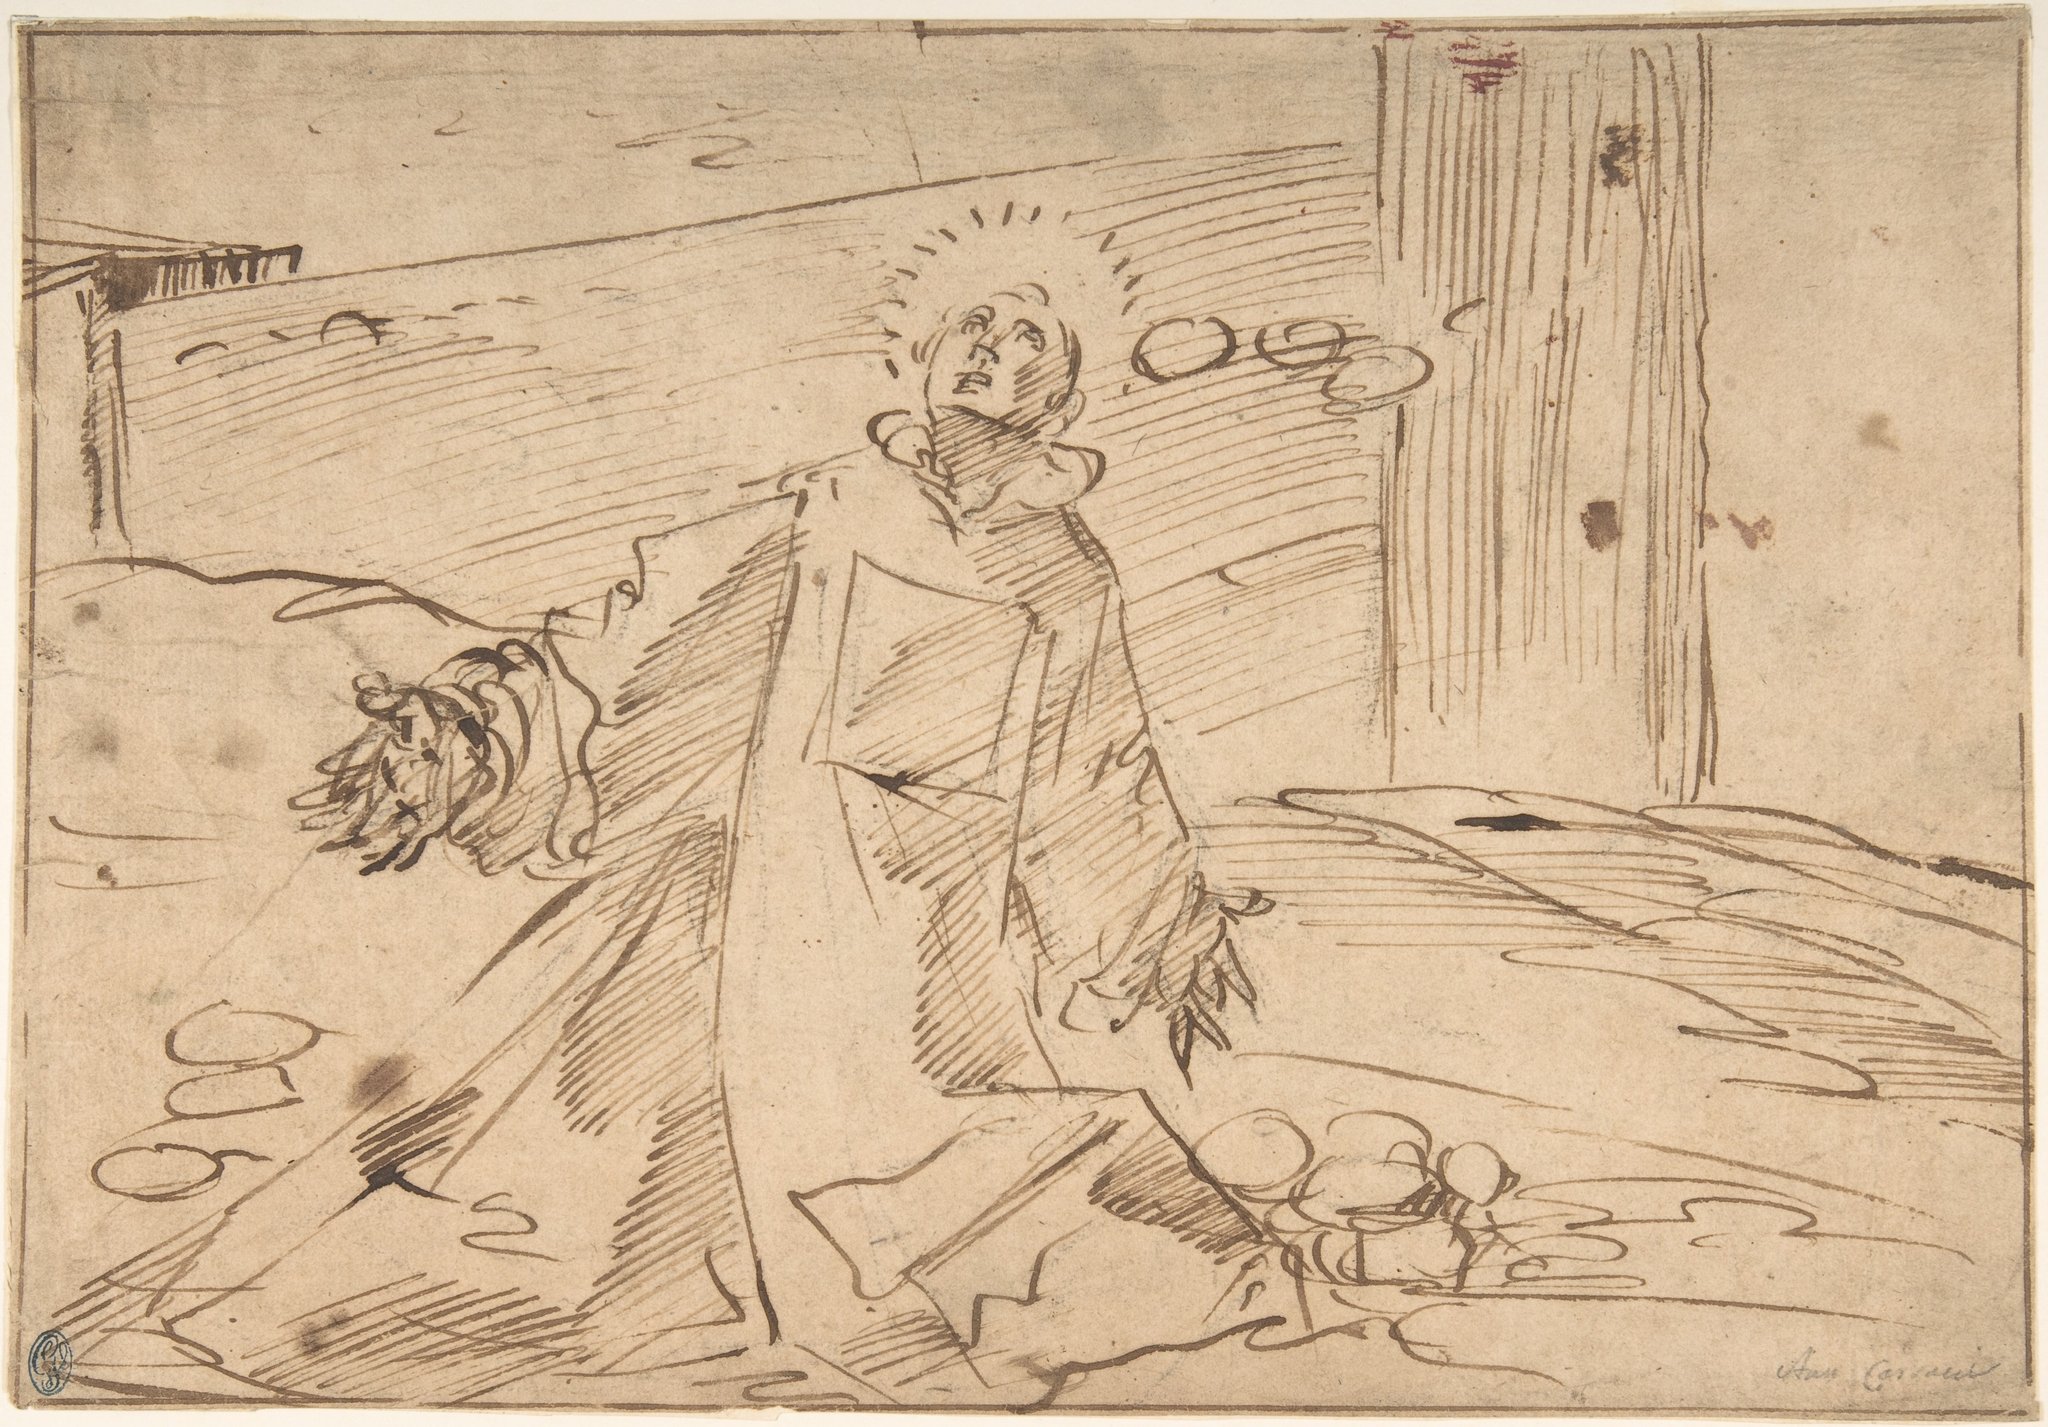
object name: drawing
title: A Saint in Ecstasy (?)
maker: anonymous, italian, 16th century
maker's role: artist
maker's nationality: italian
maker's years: 1550-1600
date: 1501-1600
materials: chalk, ink, paper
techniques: pen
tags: men,saints